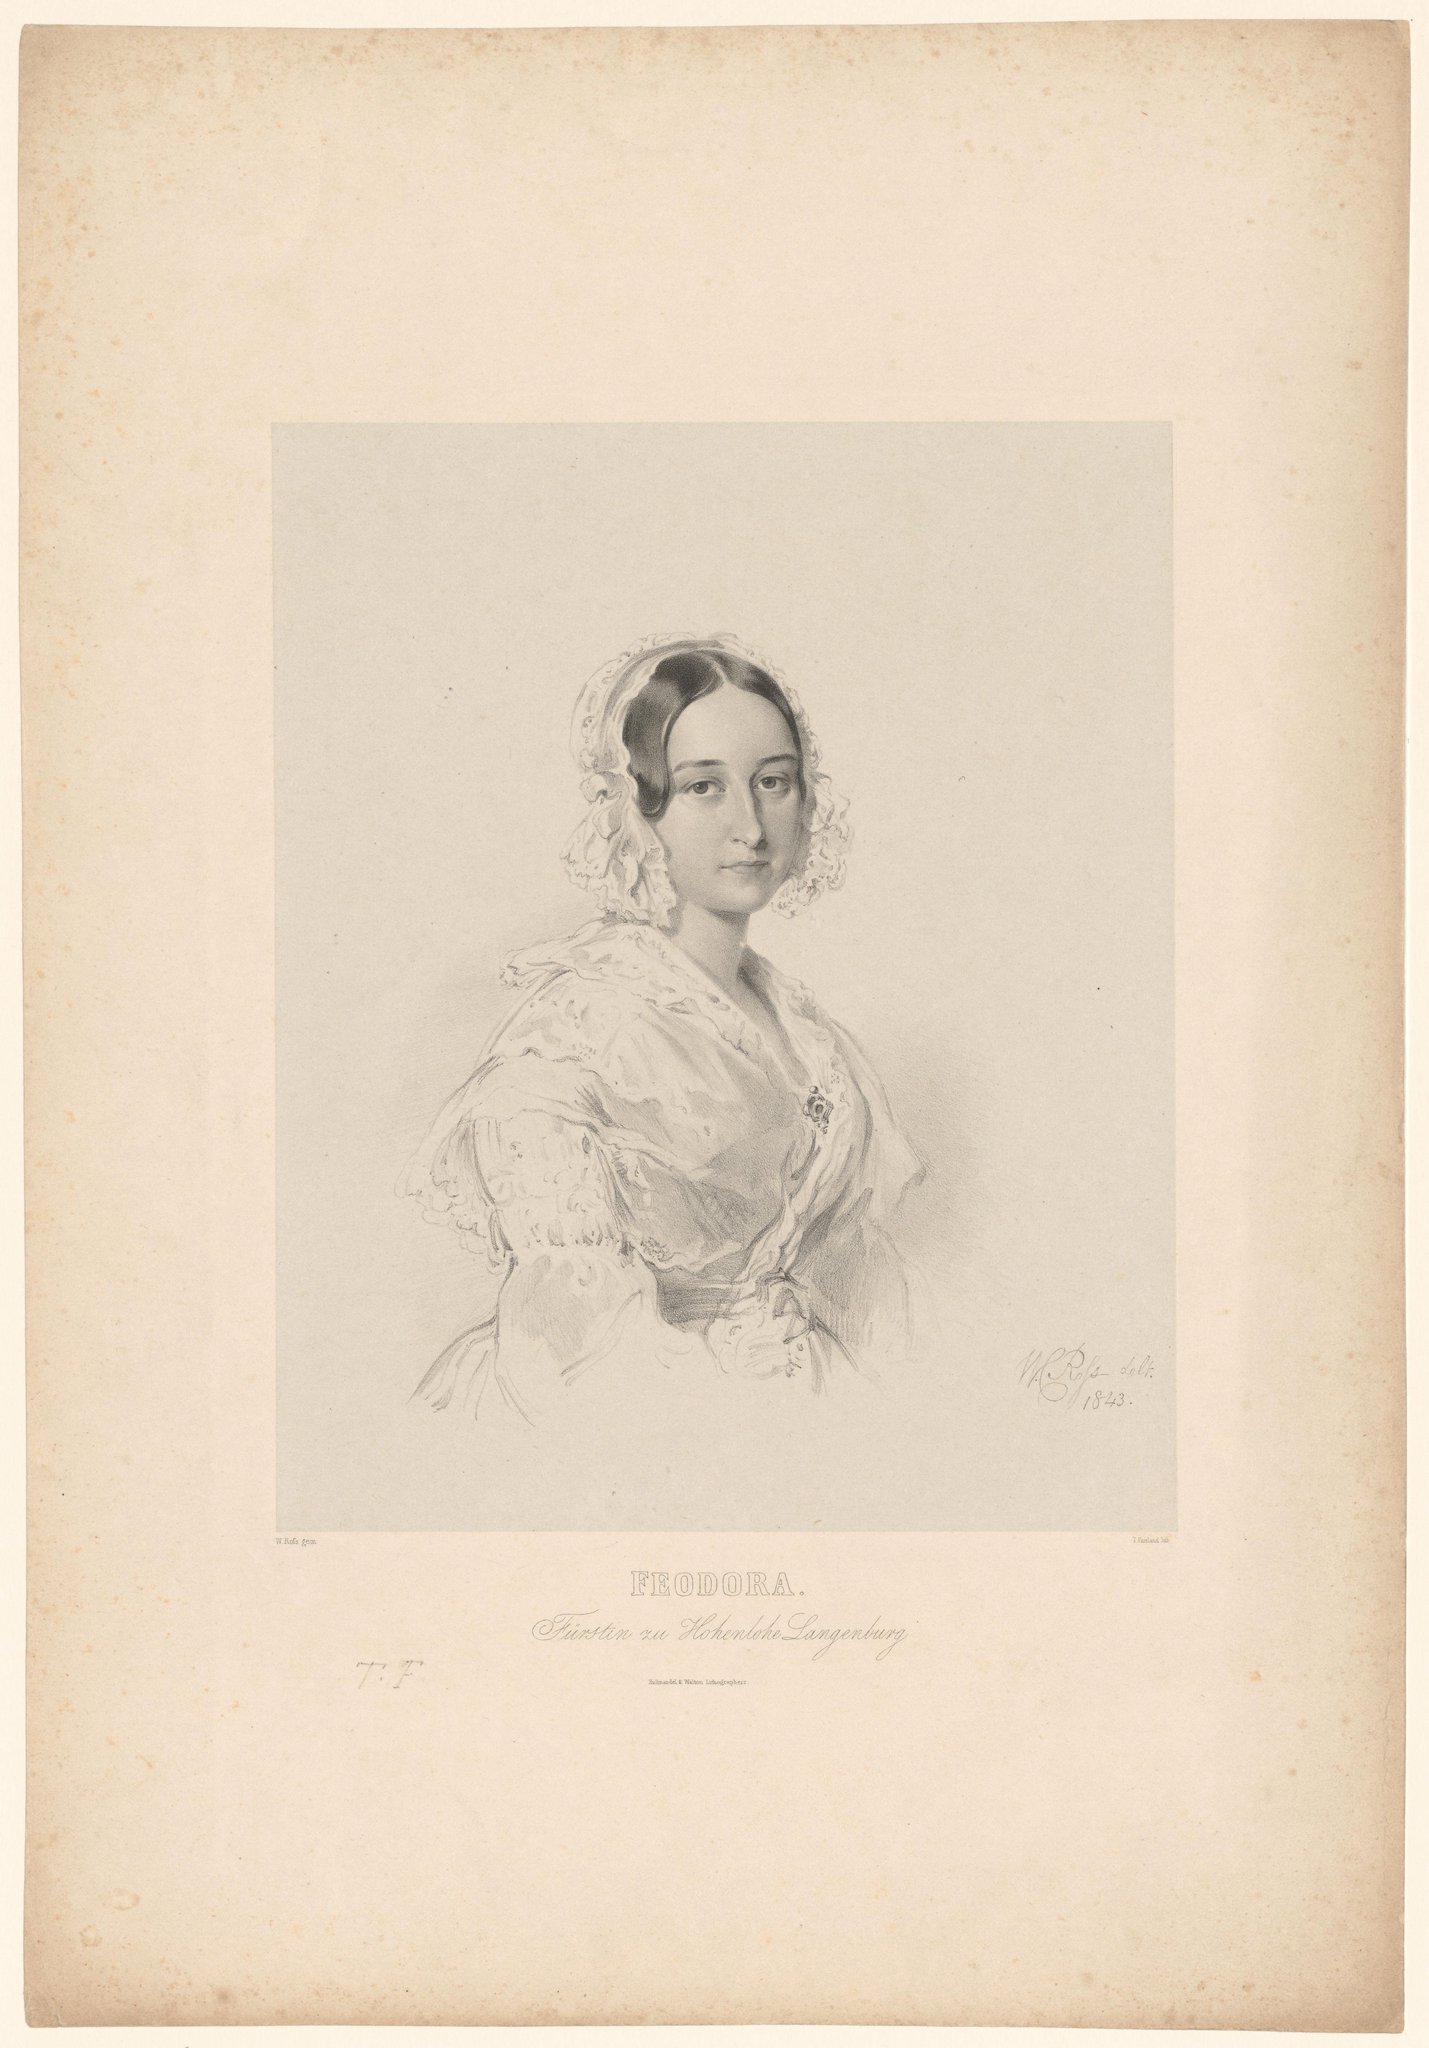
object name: print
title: Feodora, Fürstin zu Hohenlohe Langenburg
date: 1843-1850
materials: paper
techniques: lithograph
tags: adult woman, historical persons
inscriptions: collector's mark: Lugt 2228